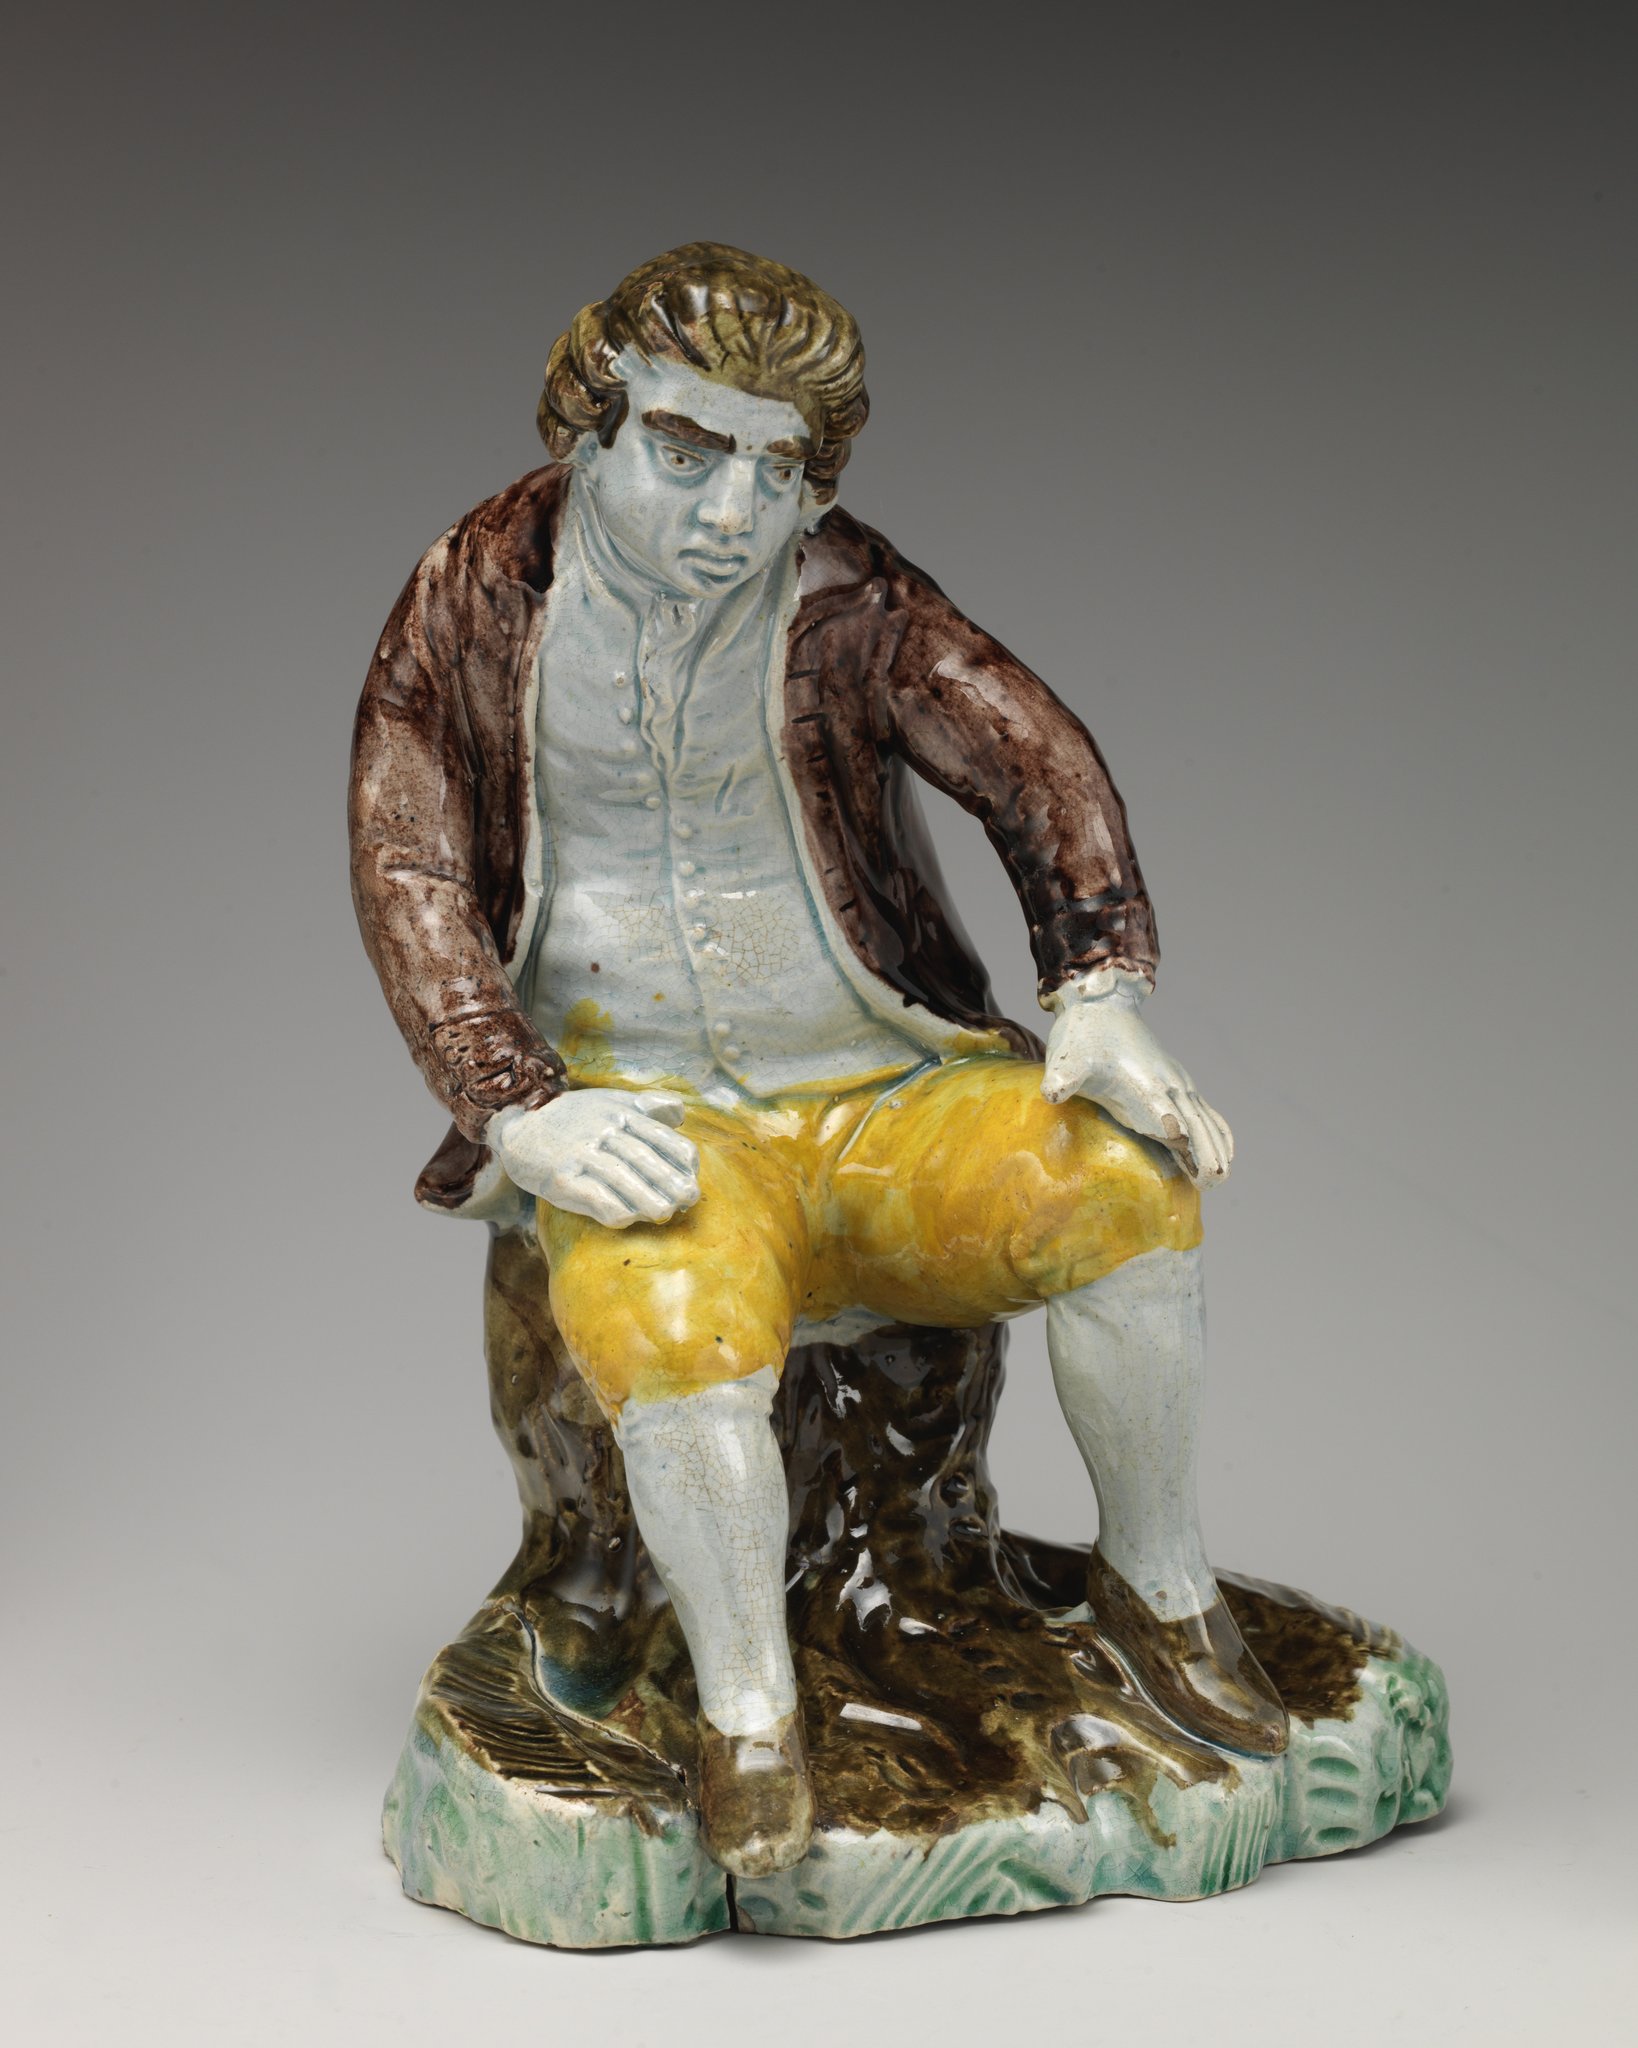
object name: figure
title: Charles James Fox, English writer and M.P. (1749–1806)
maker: ralph wood the younger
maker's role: maker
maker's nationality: british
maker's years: 1748-1795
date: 1770-1780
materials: earthenware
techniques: glazing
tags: men